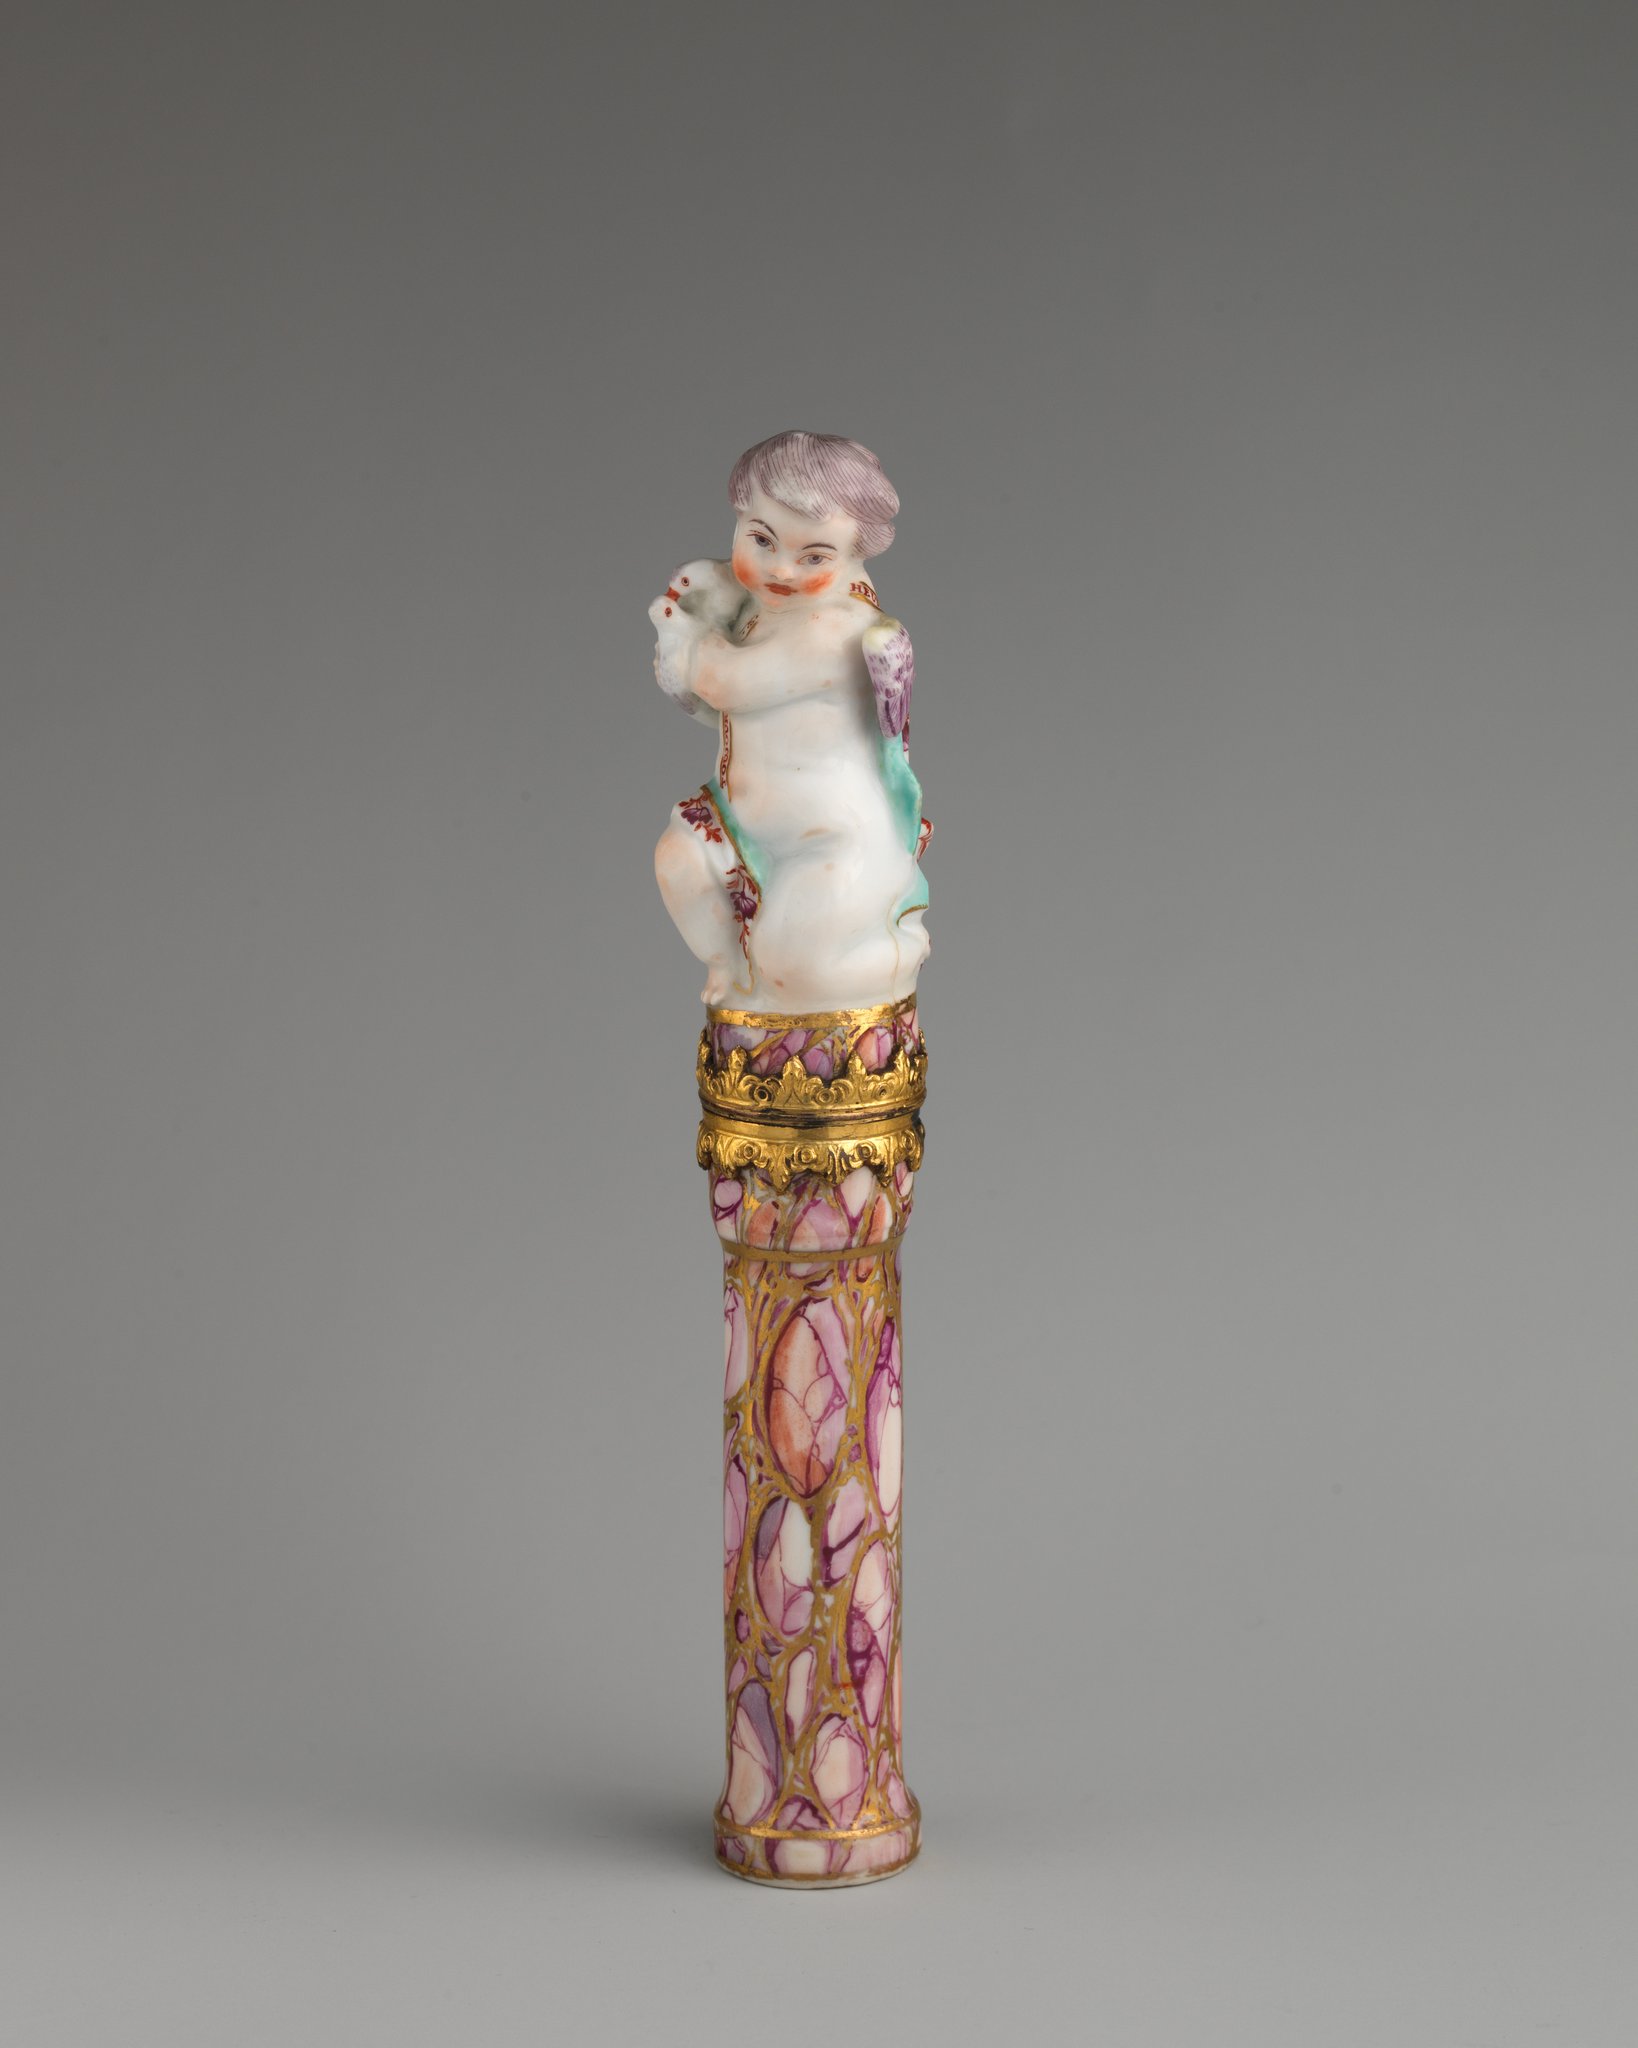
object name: toy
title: Cupid and doves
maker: chelsea porcelain manufactory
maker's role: factory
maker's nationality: british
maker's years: 1744-1784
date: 1760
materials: soft paste porcelain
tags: doves,cupid